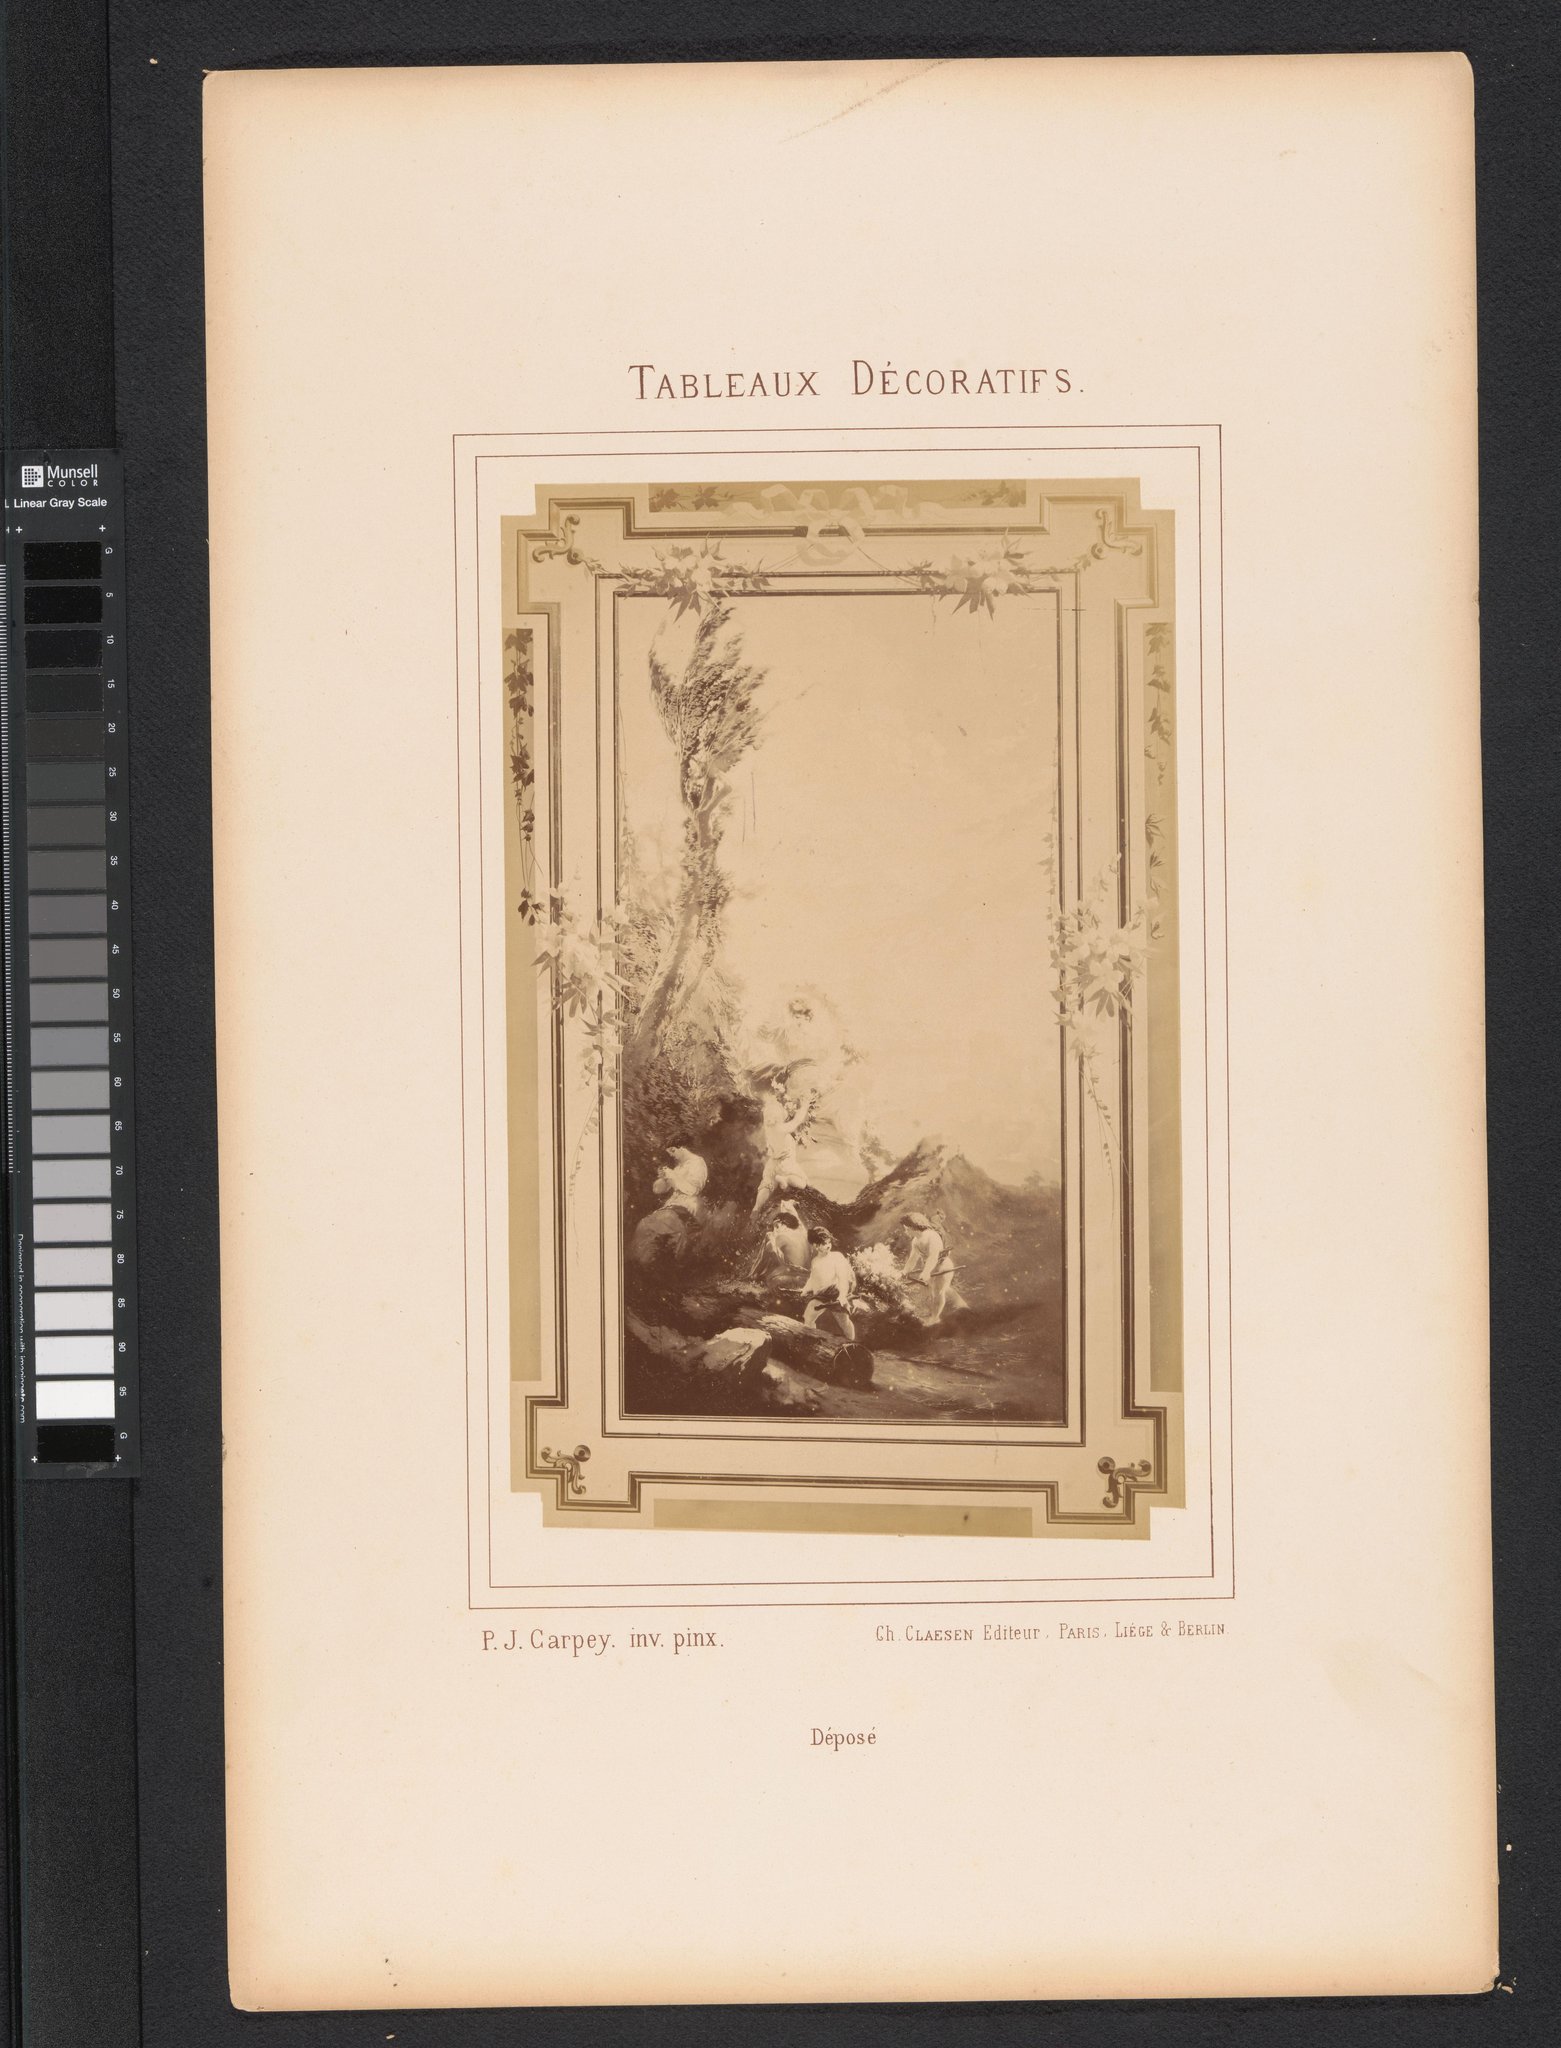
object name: reproduction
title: Déposé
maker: paul-joseph carpay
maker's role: painter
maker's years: 1822-1892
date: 1874-1881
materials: photographic support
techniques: albumen print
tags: adult woman, child, playing in the woods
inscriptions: inscription: ‘Ch. Claesen Editeur , Paris , Liége & Berlin’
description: Deze foto maakt deel uit van een omslag met 24 foto's op 22 bladen.